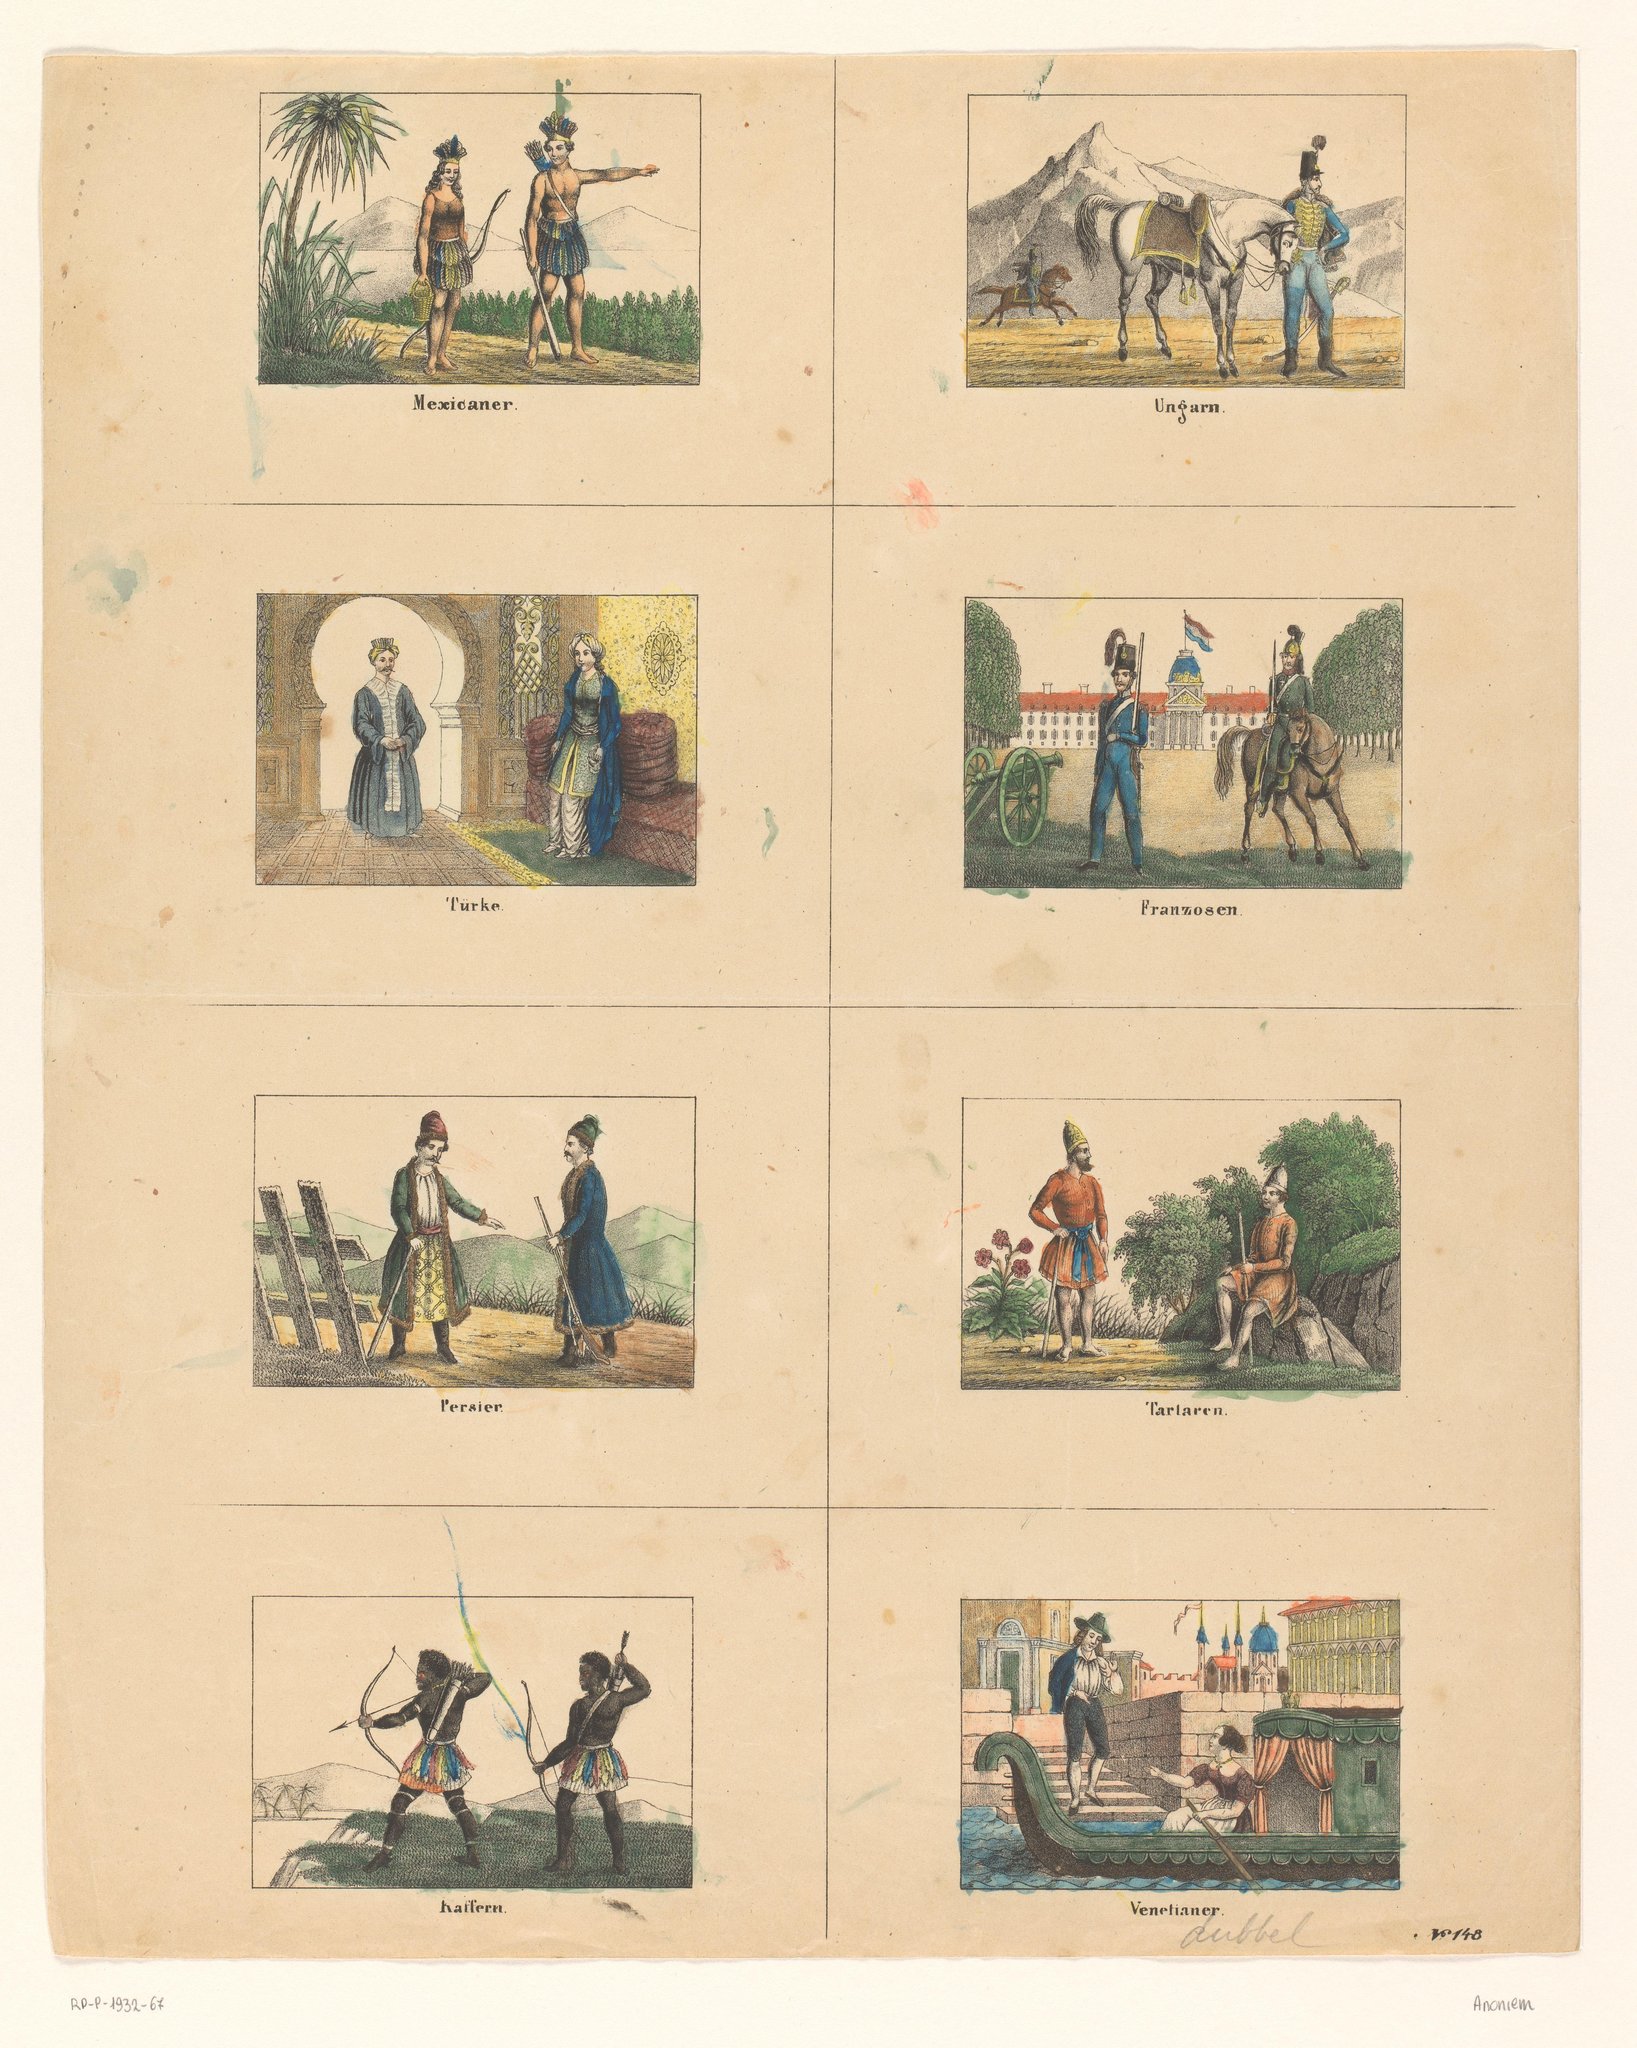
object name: print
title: Acht voorstellingen met verschillende volkeren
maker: Anonymous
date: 1800-1899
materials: paper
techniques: hand coloring, lithograph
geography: germany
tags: archer's weapons: bow and arrow, asiatic races and peoples: turks, europeans (with name), asiatic races and peoples (tatars), gondola, asiatic races and peoples: persians